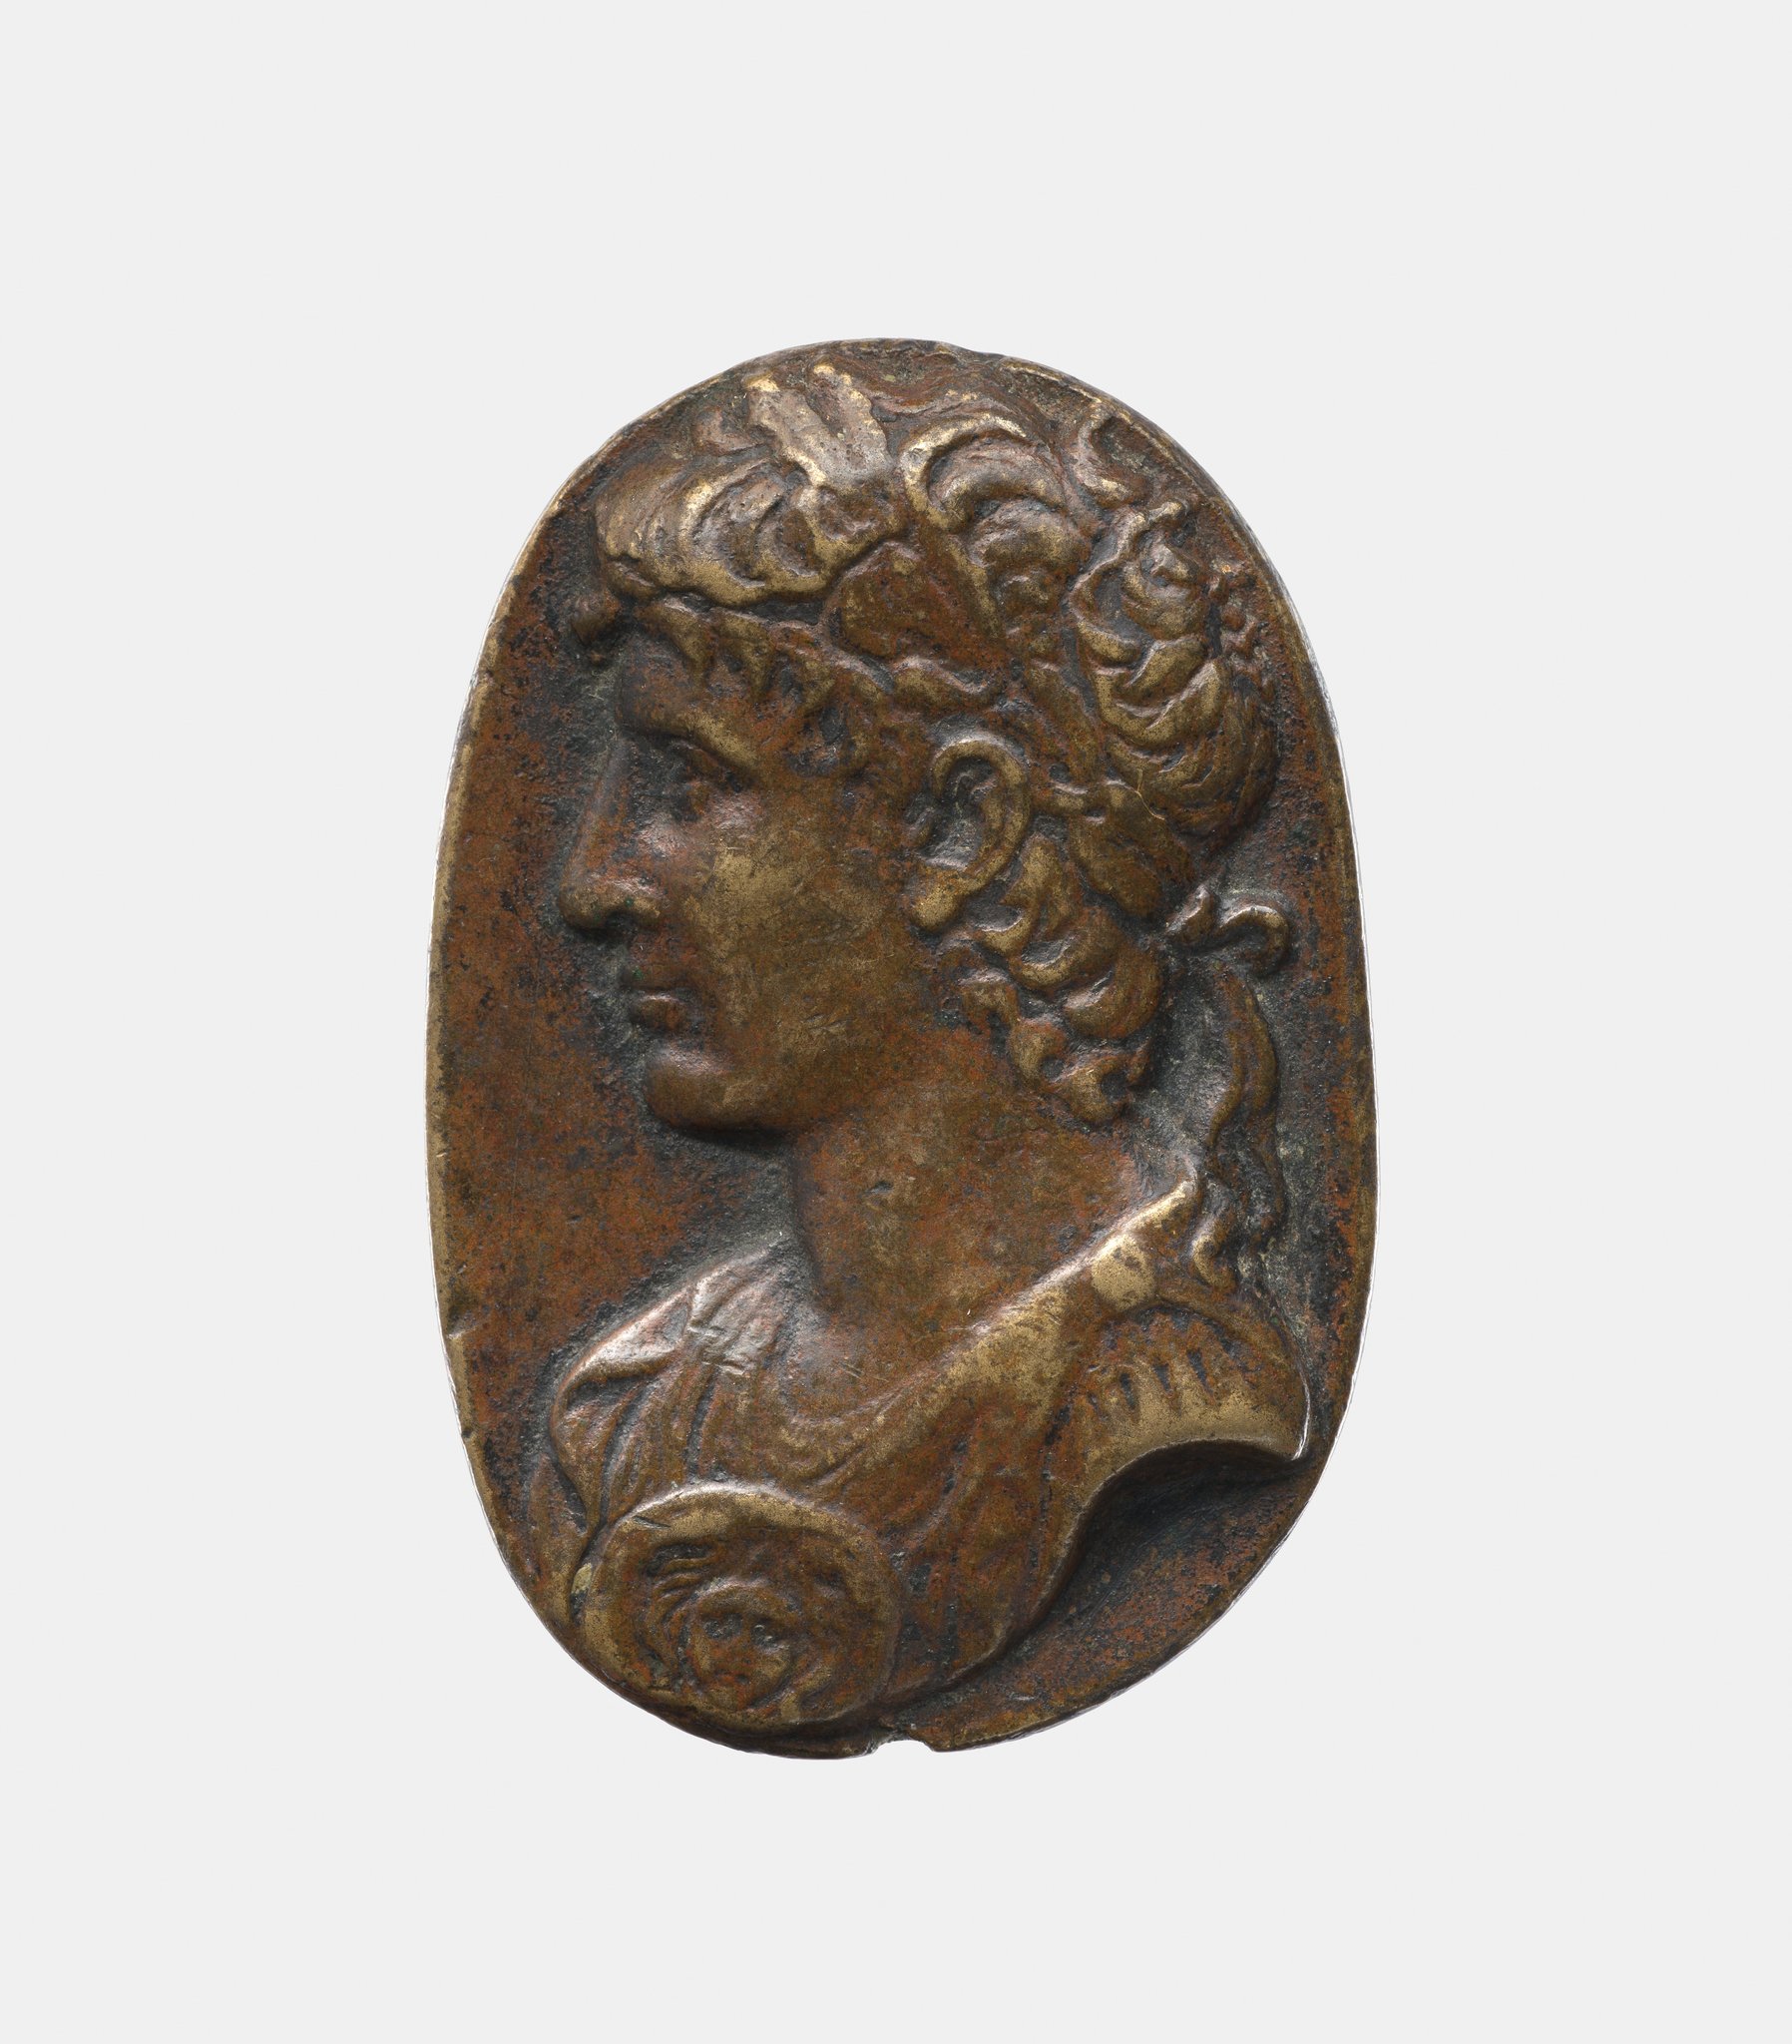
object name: plaquette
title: Emperor Augustus 31 B.C.-A.D. 14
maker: Anonymous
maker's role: artist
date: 1400-1499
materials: bronze